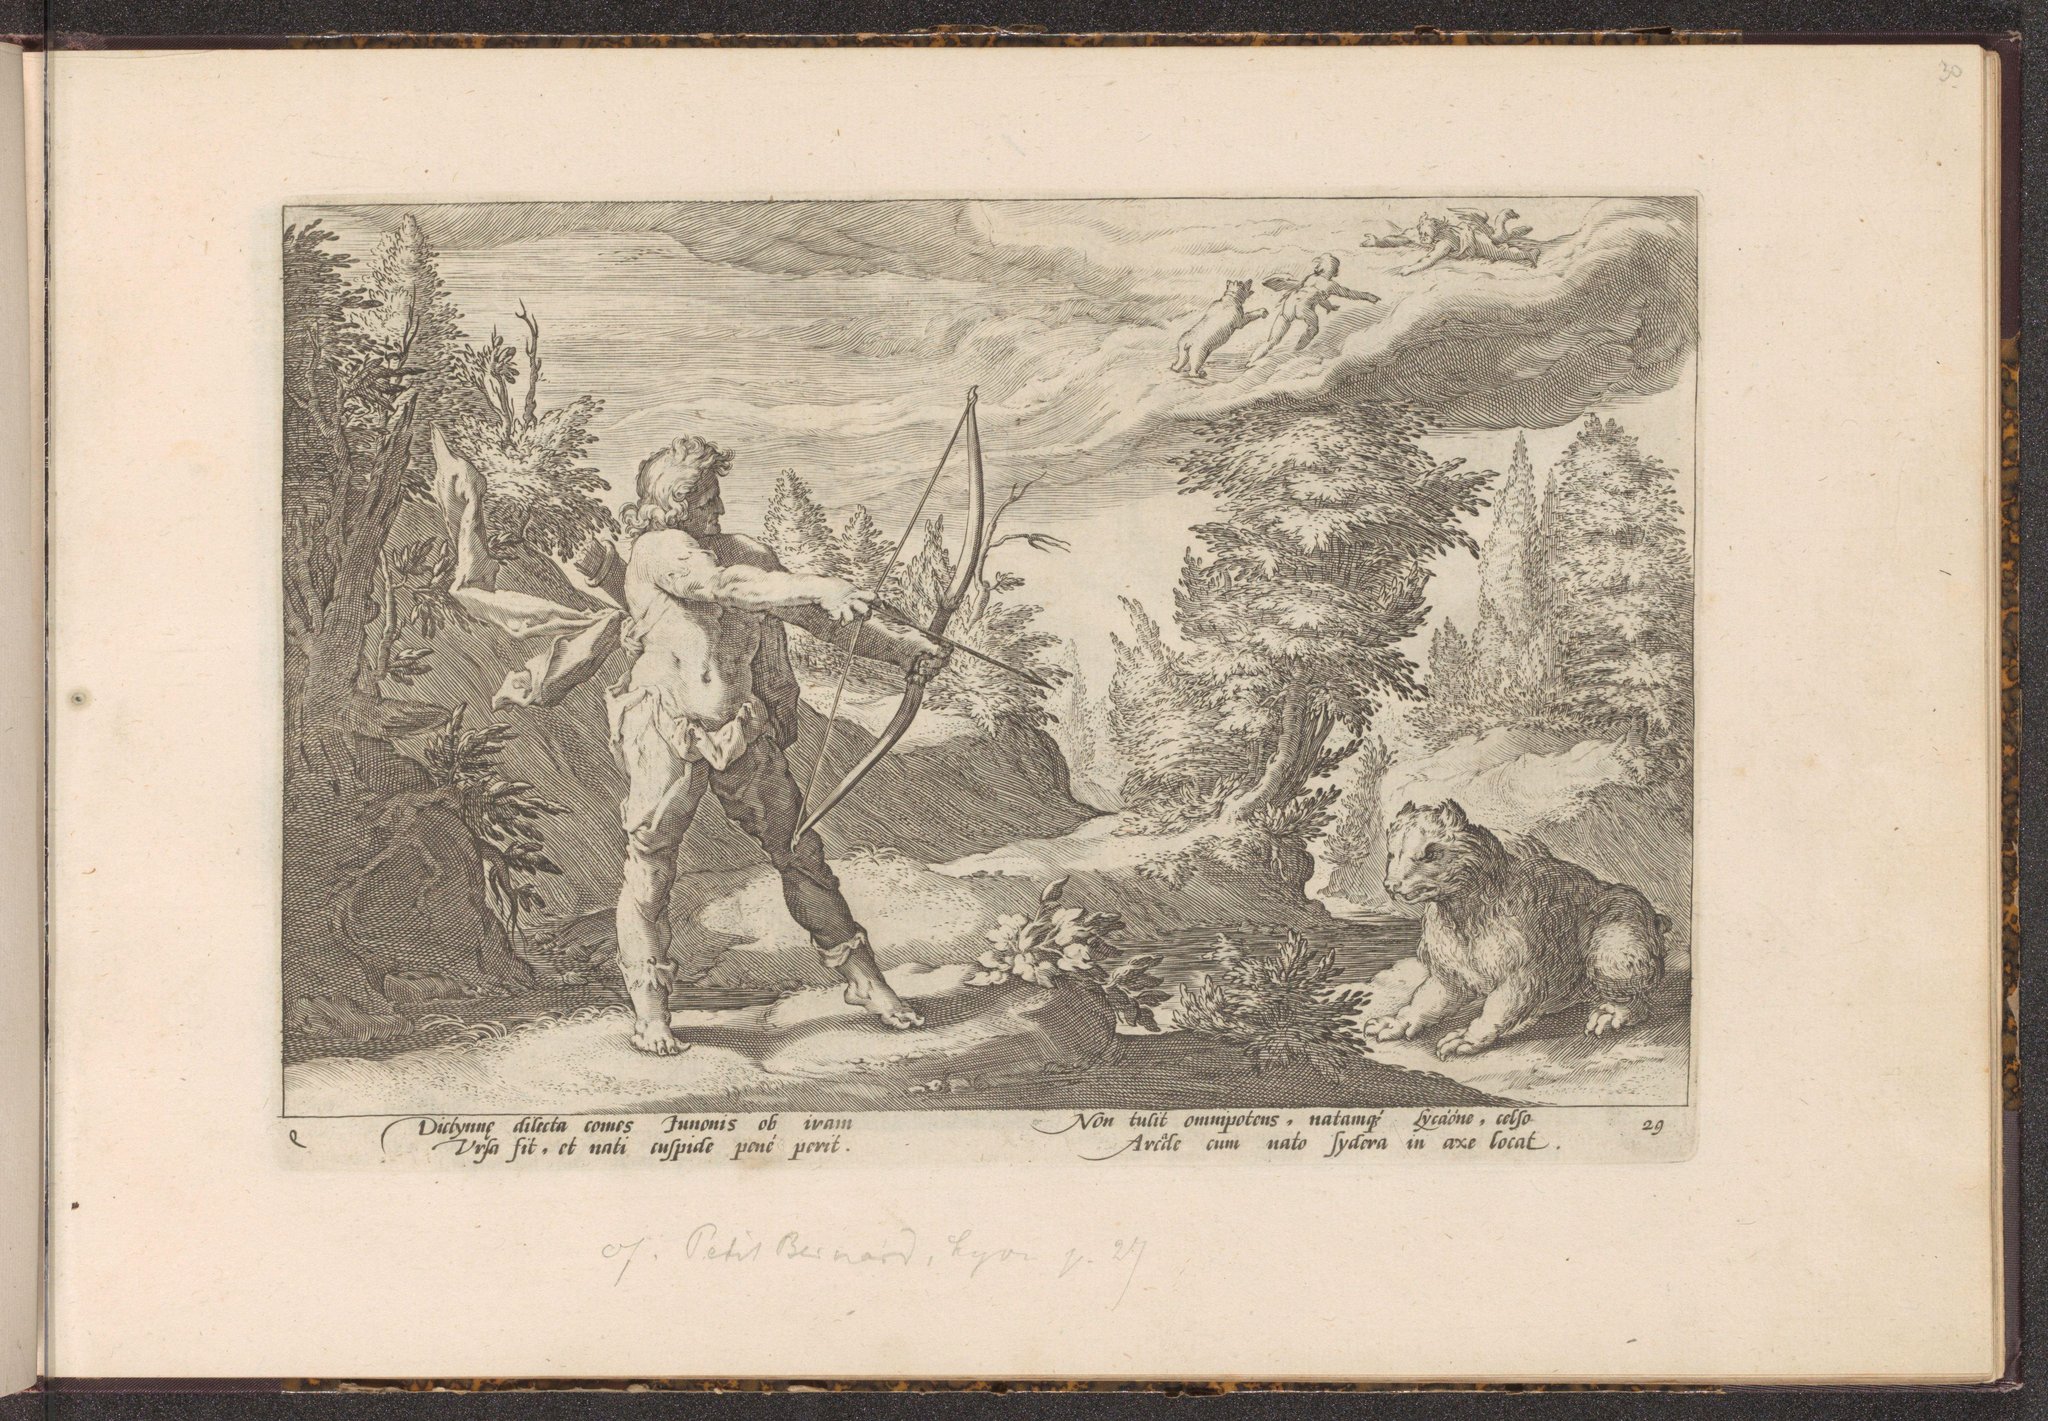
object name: print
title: Herscheppingen van P. Ovidius Naso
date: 1590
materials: paper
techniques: engraving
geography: amsterdam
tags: arcas changed into a constellation: when arcas is about to shoot the bear into which his mother, callisto, has been changed, jupiter turns him into a constellation (ovid, metamorphoses ii 506), callisto is hunted by her son arcas, callisto changed into a constellation: jupiter changes callisto into a constellation, when, transformed into a bear she is about to be shot by arcas (ovid, metamorphoses ii 506)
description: Arcas, de zoon van Jupiter en Callisto, richt zijn pijl op een beer, niet wetend dat dat zijn moeder is. Zij is vijftien jaar eerder van gedaante veranderd. Op de achtergrond rechts is te zien hoe Jupiter moeder en zoon, voordat Arcas kan schieten, aan de hemel plaatst, als sterrenbeelden. Onder de voorstelling twee keer twee versregels in het Latijn. De prent maakt deel uit van een album.